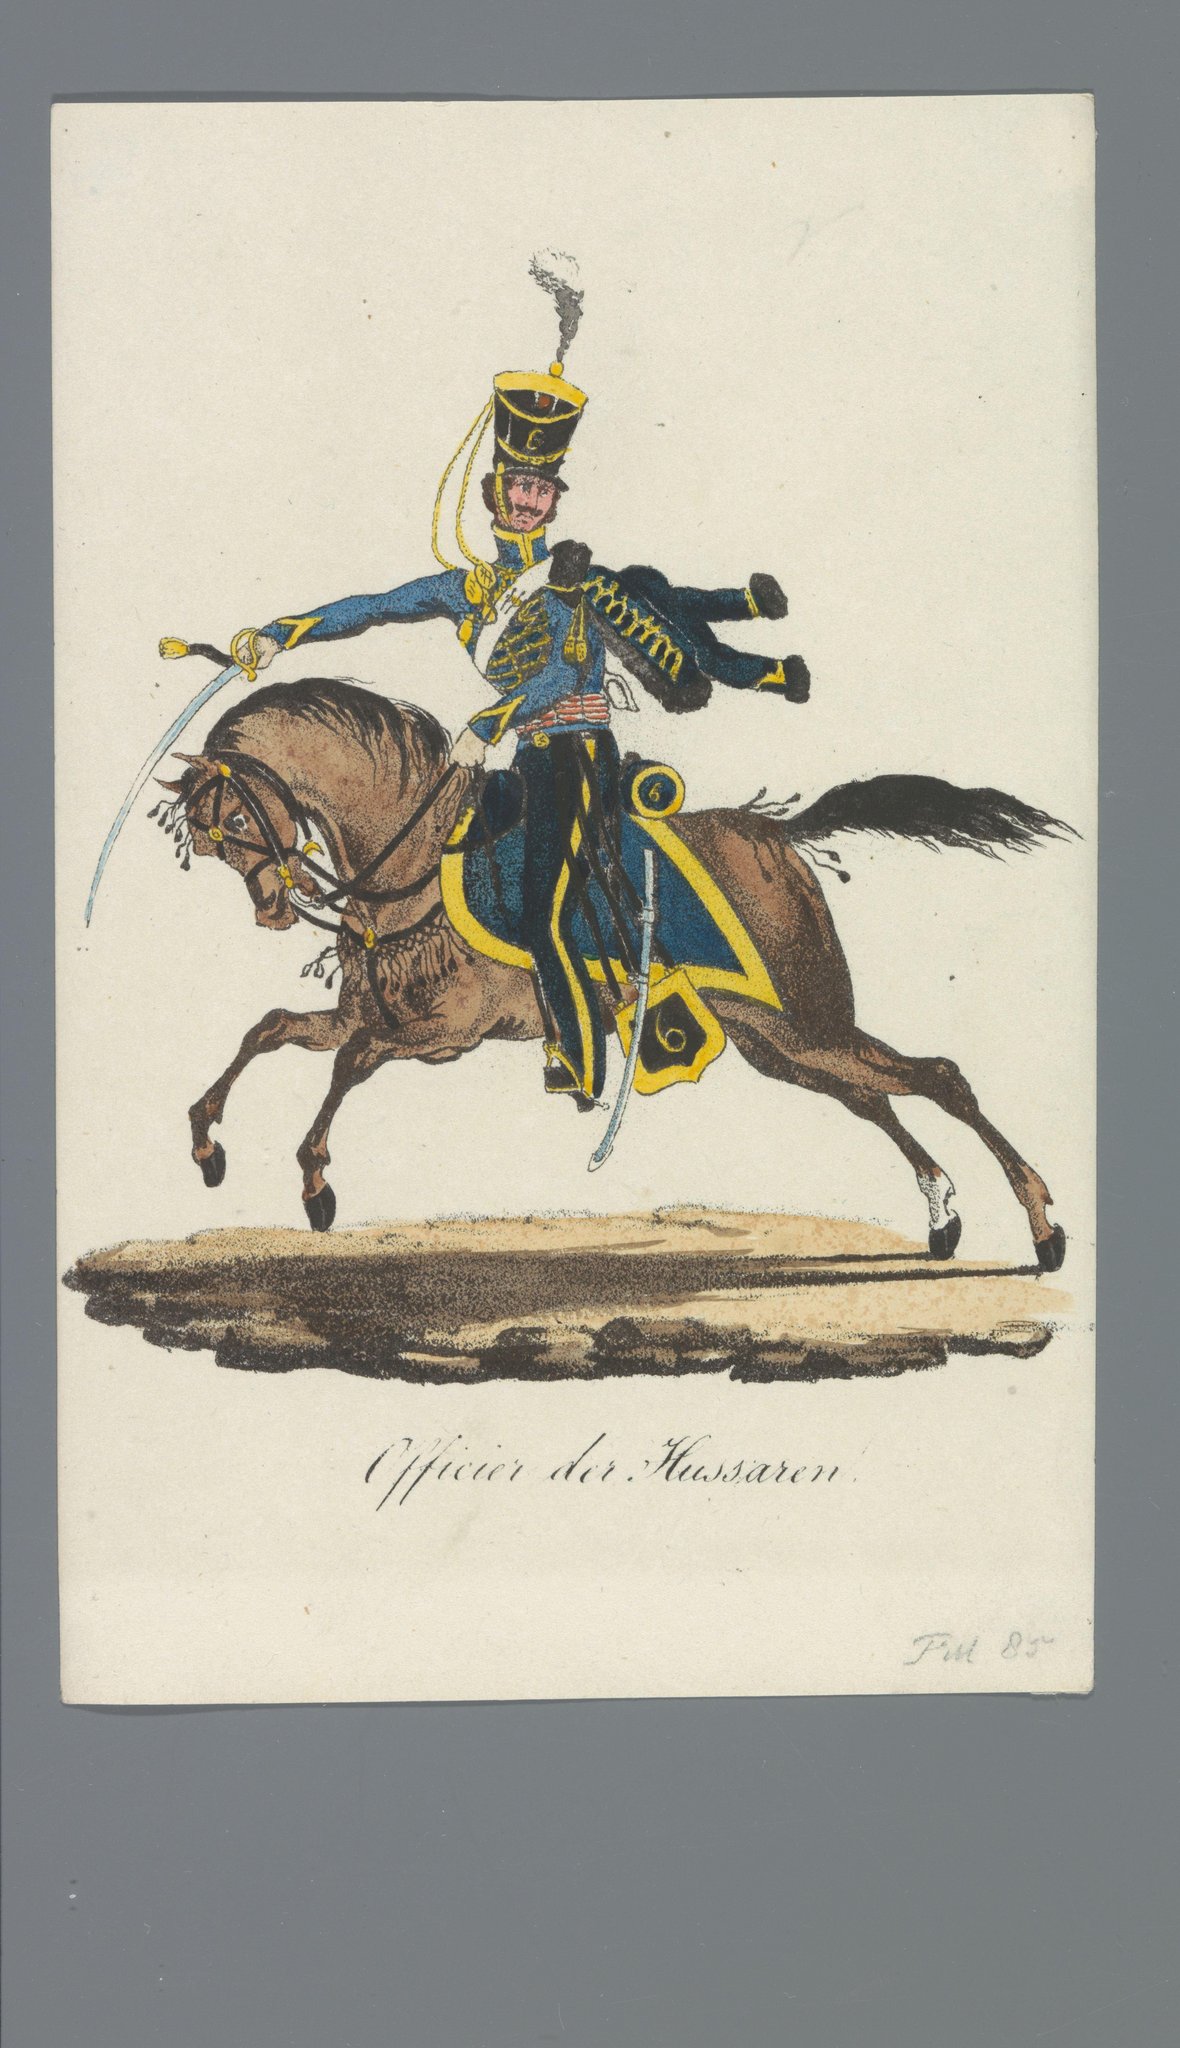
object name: print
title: Officier der Hussaren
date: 1835-1850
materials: paper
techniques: hand coloring, lithograph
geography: netherlands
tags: (military) uniforms, clothes, costume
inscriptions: collector's mark: Lugt 2228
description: Een officier van het Regiment Huzaren Nr 6, te paard. Onderdeel van een serie van 157 losse bladen met Nederlandse militaire uniformen in de jaren 1830-1832.